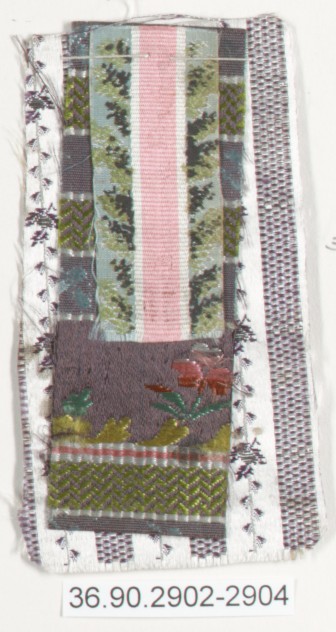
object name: piece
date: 1801-1900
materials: silk